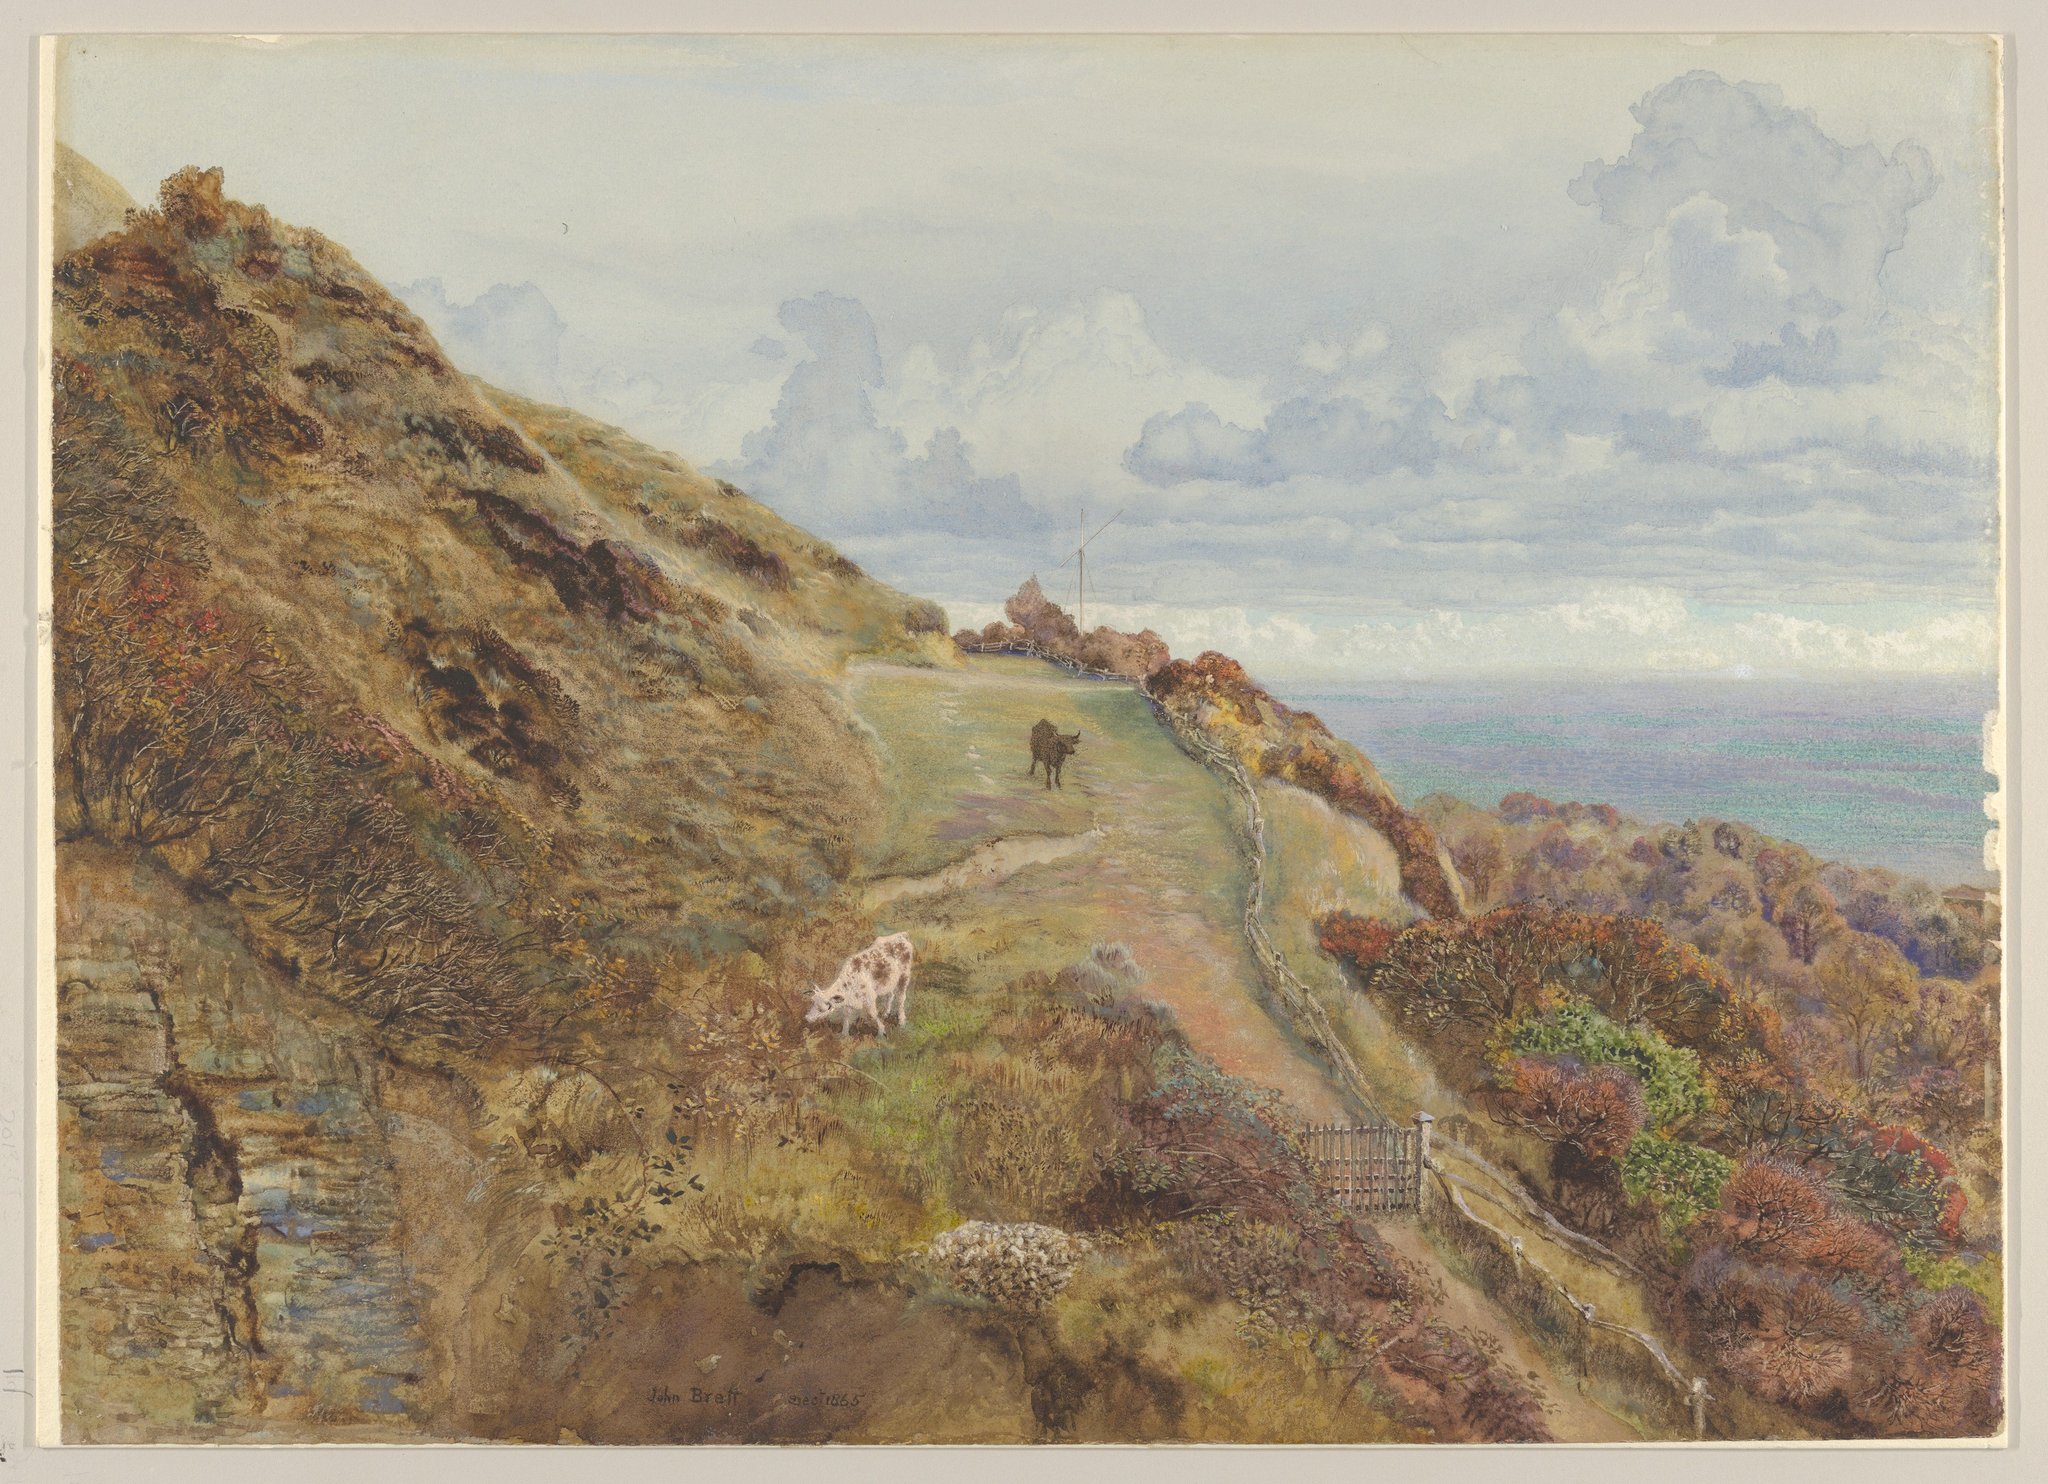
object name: drawing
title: Bonchurch Downs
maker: john brett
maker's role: artist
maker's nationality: british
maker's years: 1831-1902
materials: watercolor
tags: cows,landscapes